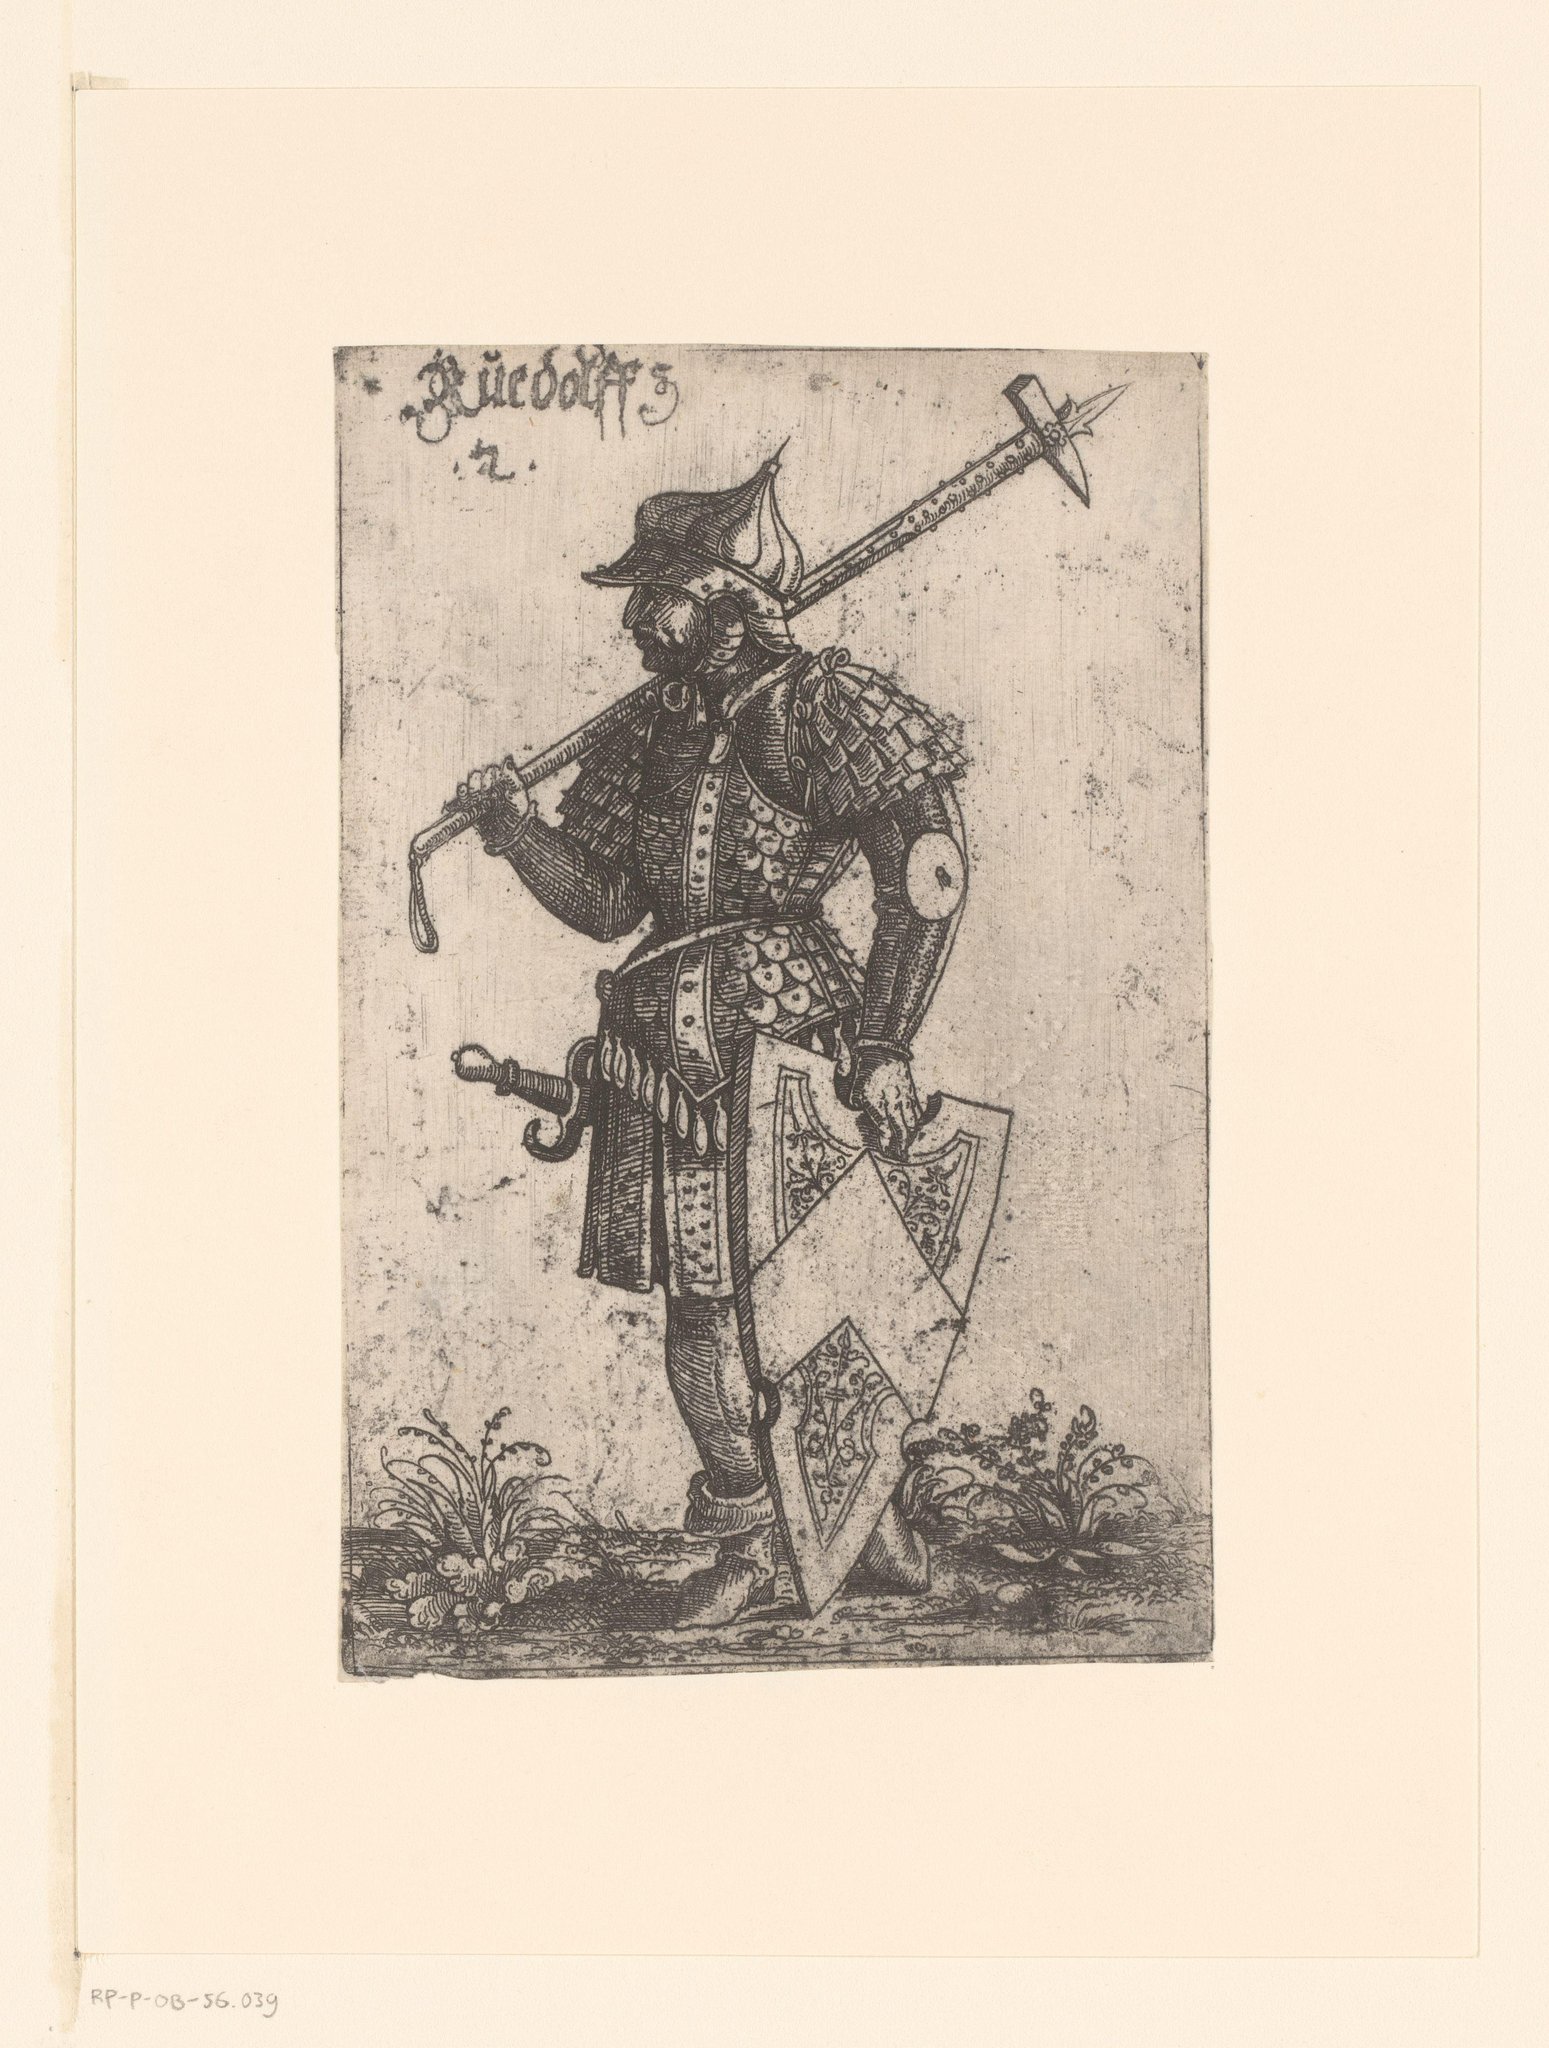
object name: print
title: Ruedolff 2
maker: heinrich vogtherr (i)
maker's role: draughtsman, print maker, publisher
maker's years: 1490-1556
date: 1500-1556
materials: paper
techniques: etching, intaglio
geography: germany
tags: protective weapons: shield, the soldier; the soldier's life, tools, aids, implements ~ crafts and industries: pickaxe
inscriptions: collector's mark: Lugt 2228